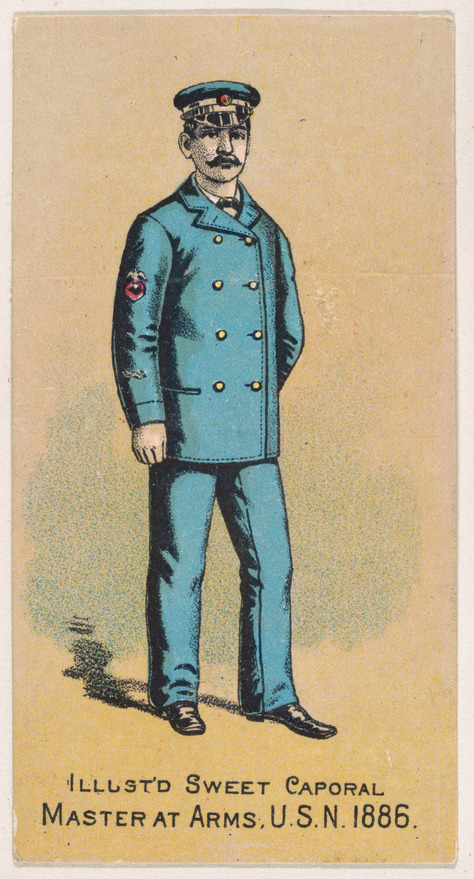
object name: print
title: Master at Arms, United States Navy, 1886, from the Military Series (N224) issued by Kinney Tobacco Company to promote Sweet Caporal Cigarettes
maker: kinney brothers tobacco company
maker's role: publisher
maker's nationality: american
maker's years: 1869-2011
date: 1888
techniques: color lithograph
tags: military,men